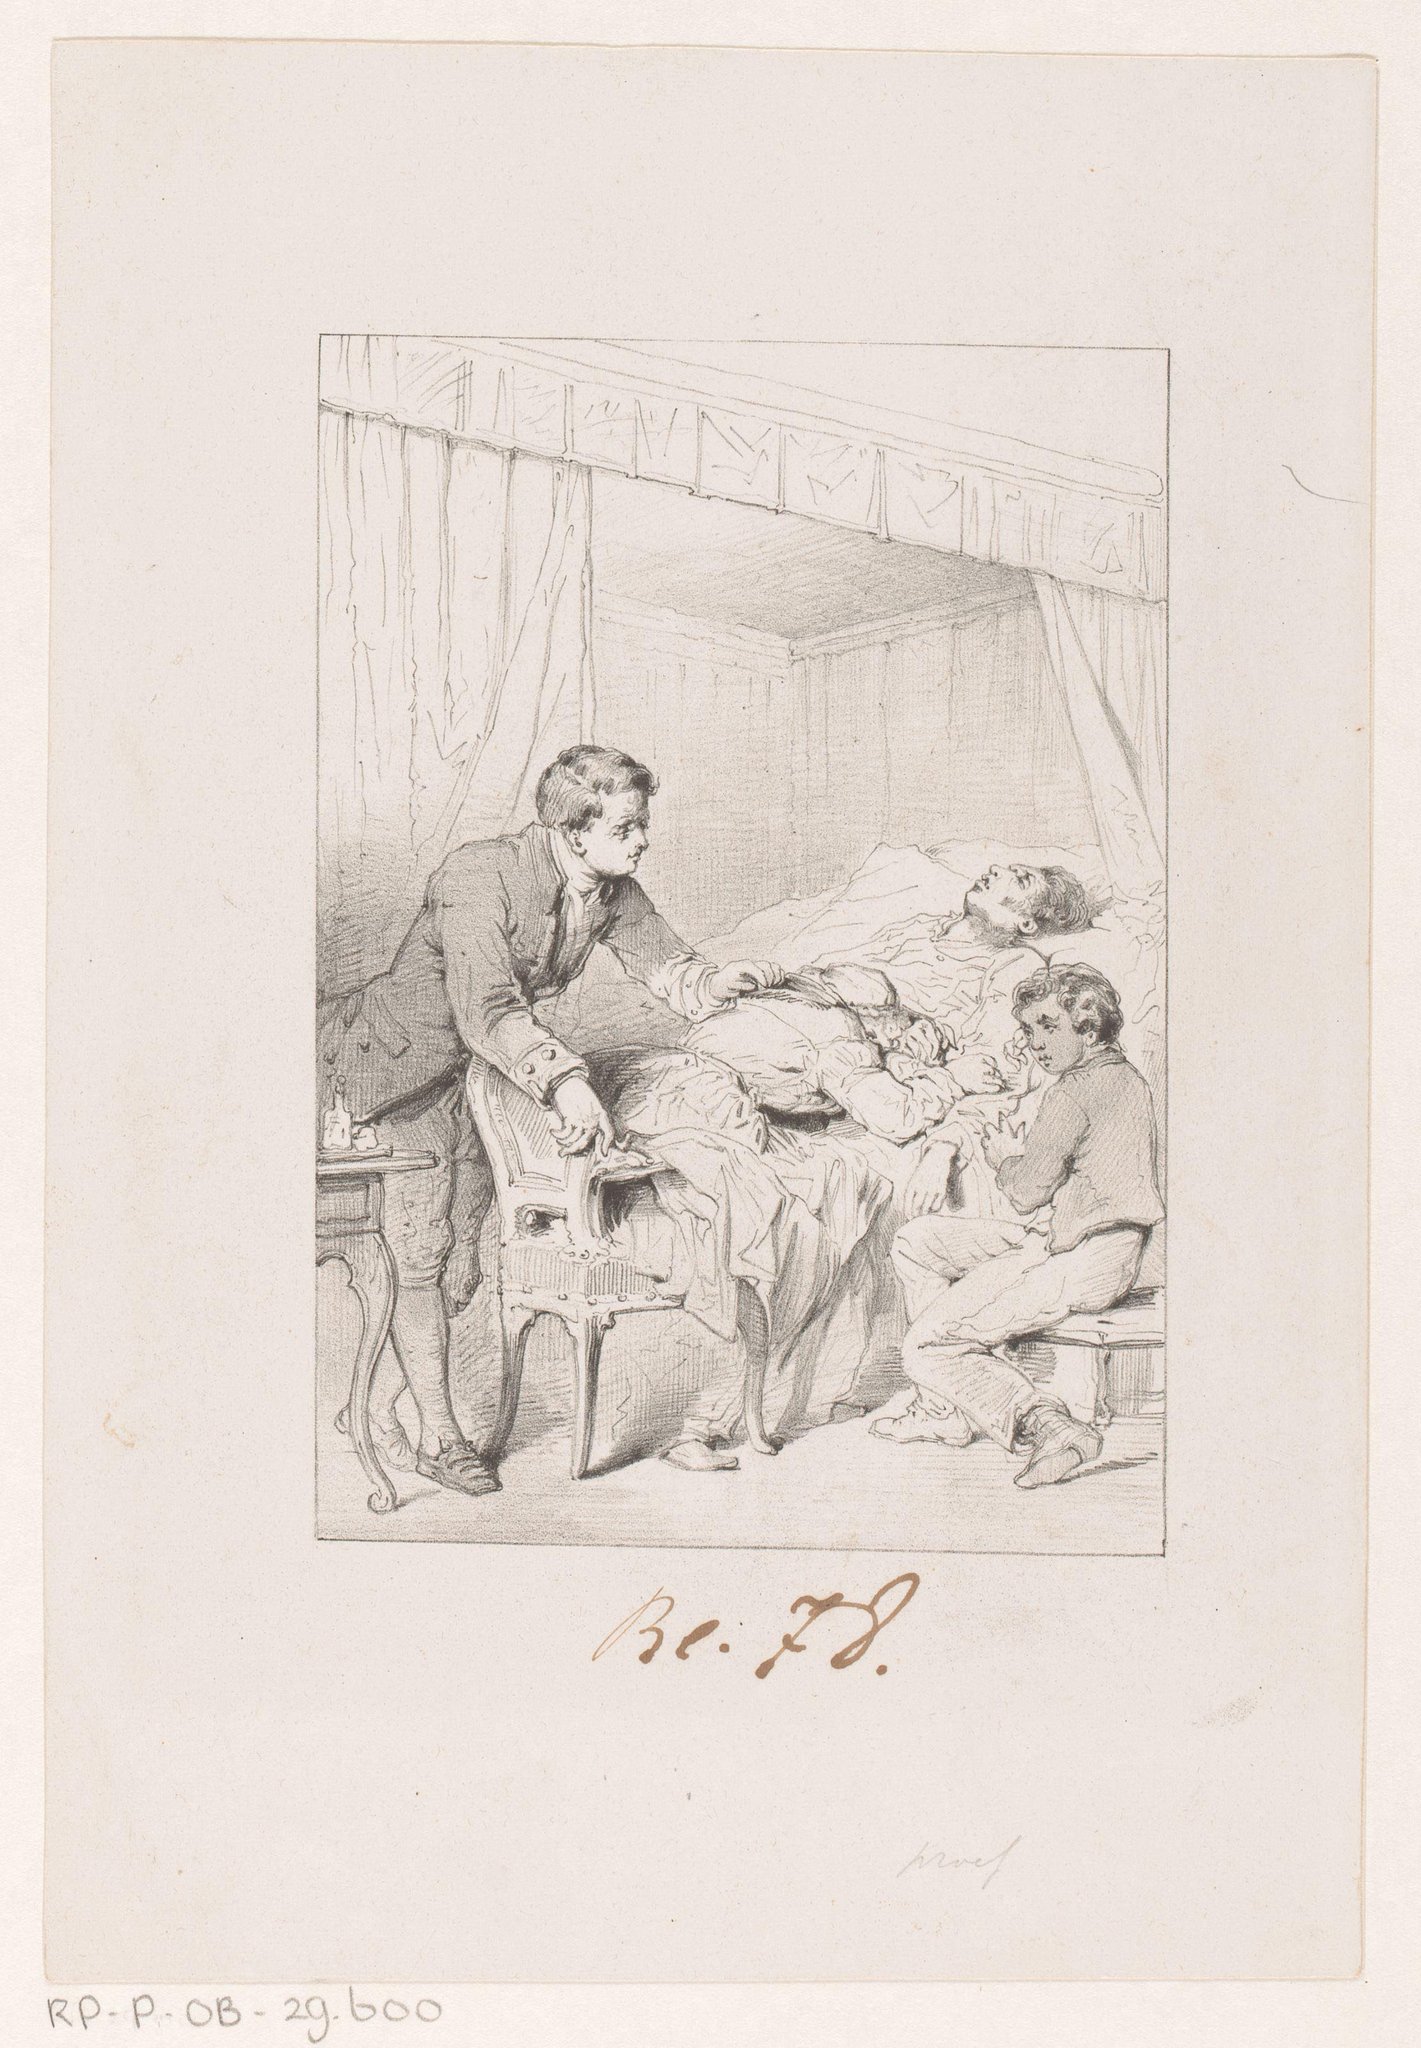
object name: print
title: Treurende mensen rondom stervende figuur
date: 1832-1891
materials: paper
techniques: lithograph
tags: mourning the dead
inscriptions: collector's mark: Lugt 2228, inscription: ‘Bl. 78’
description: Drie treurende familieleden rondom een stervende figuur in bed.